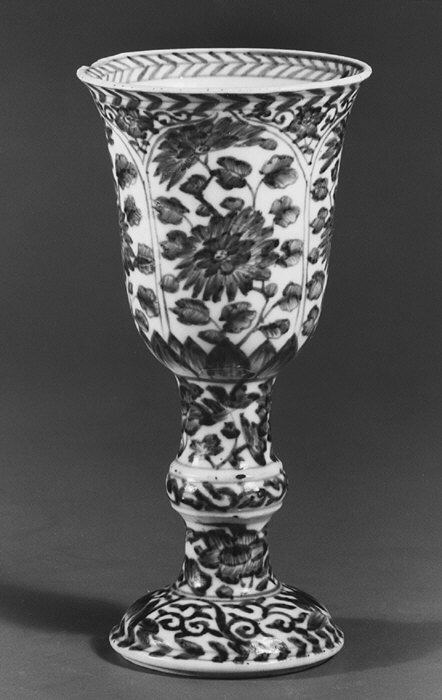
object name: cup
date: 1700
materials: hard paste porcelain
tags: flowers